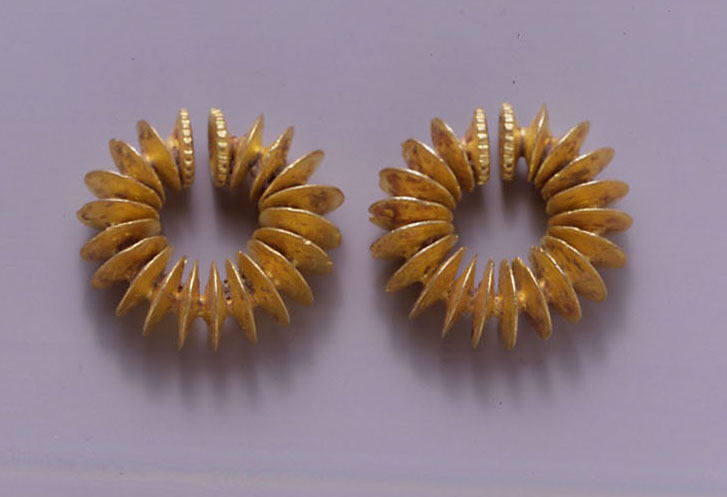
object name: ear clip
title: Pair of Ear Clips Composed of Fused Discs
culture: indonesian, javanese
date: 701-933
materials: gold